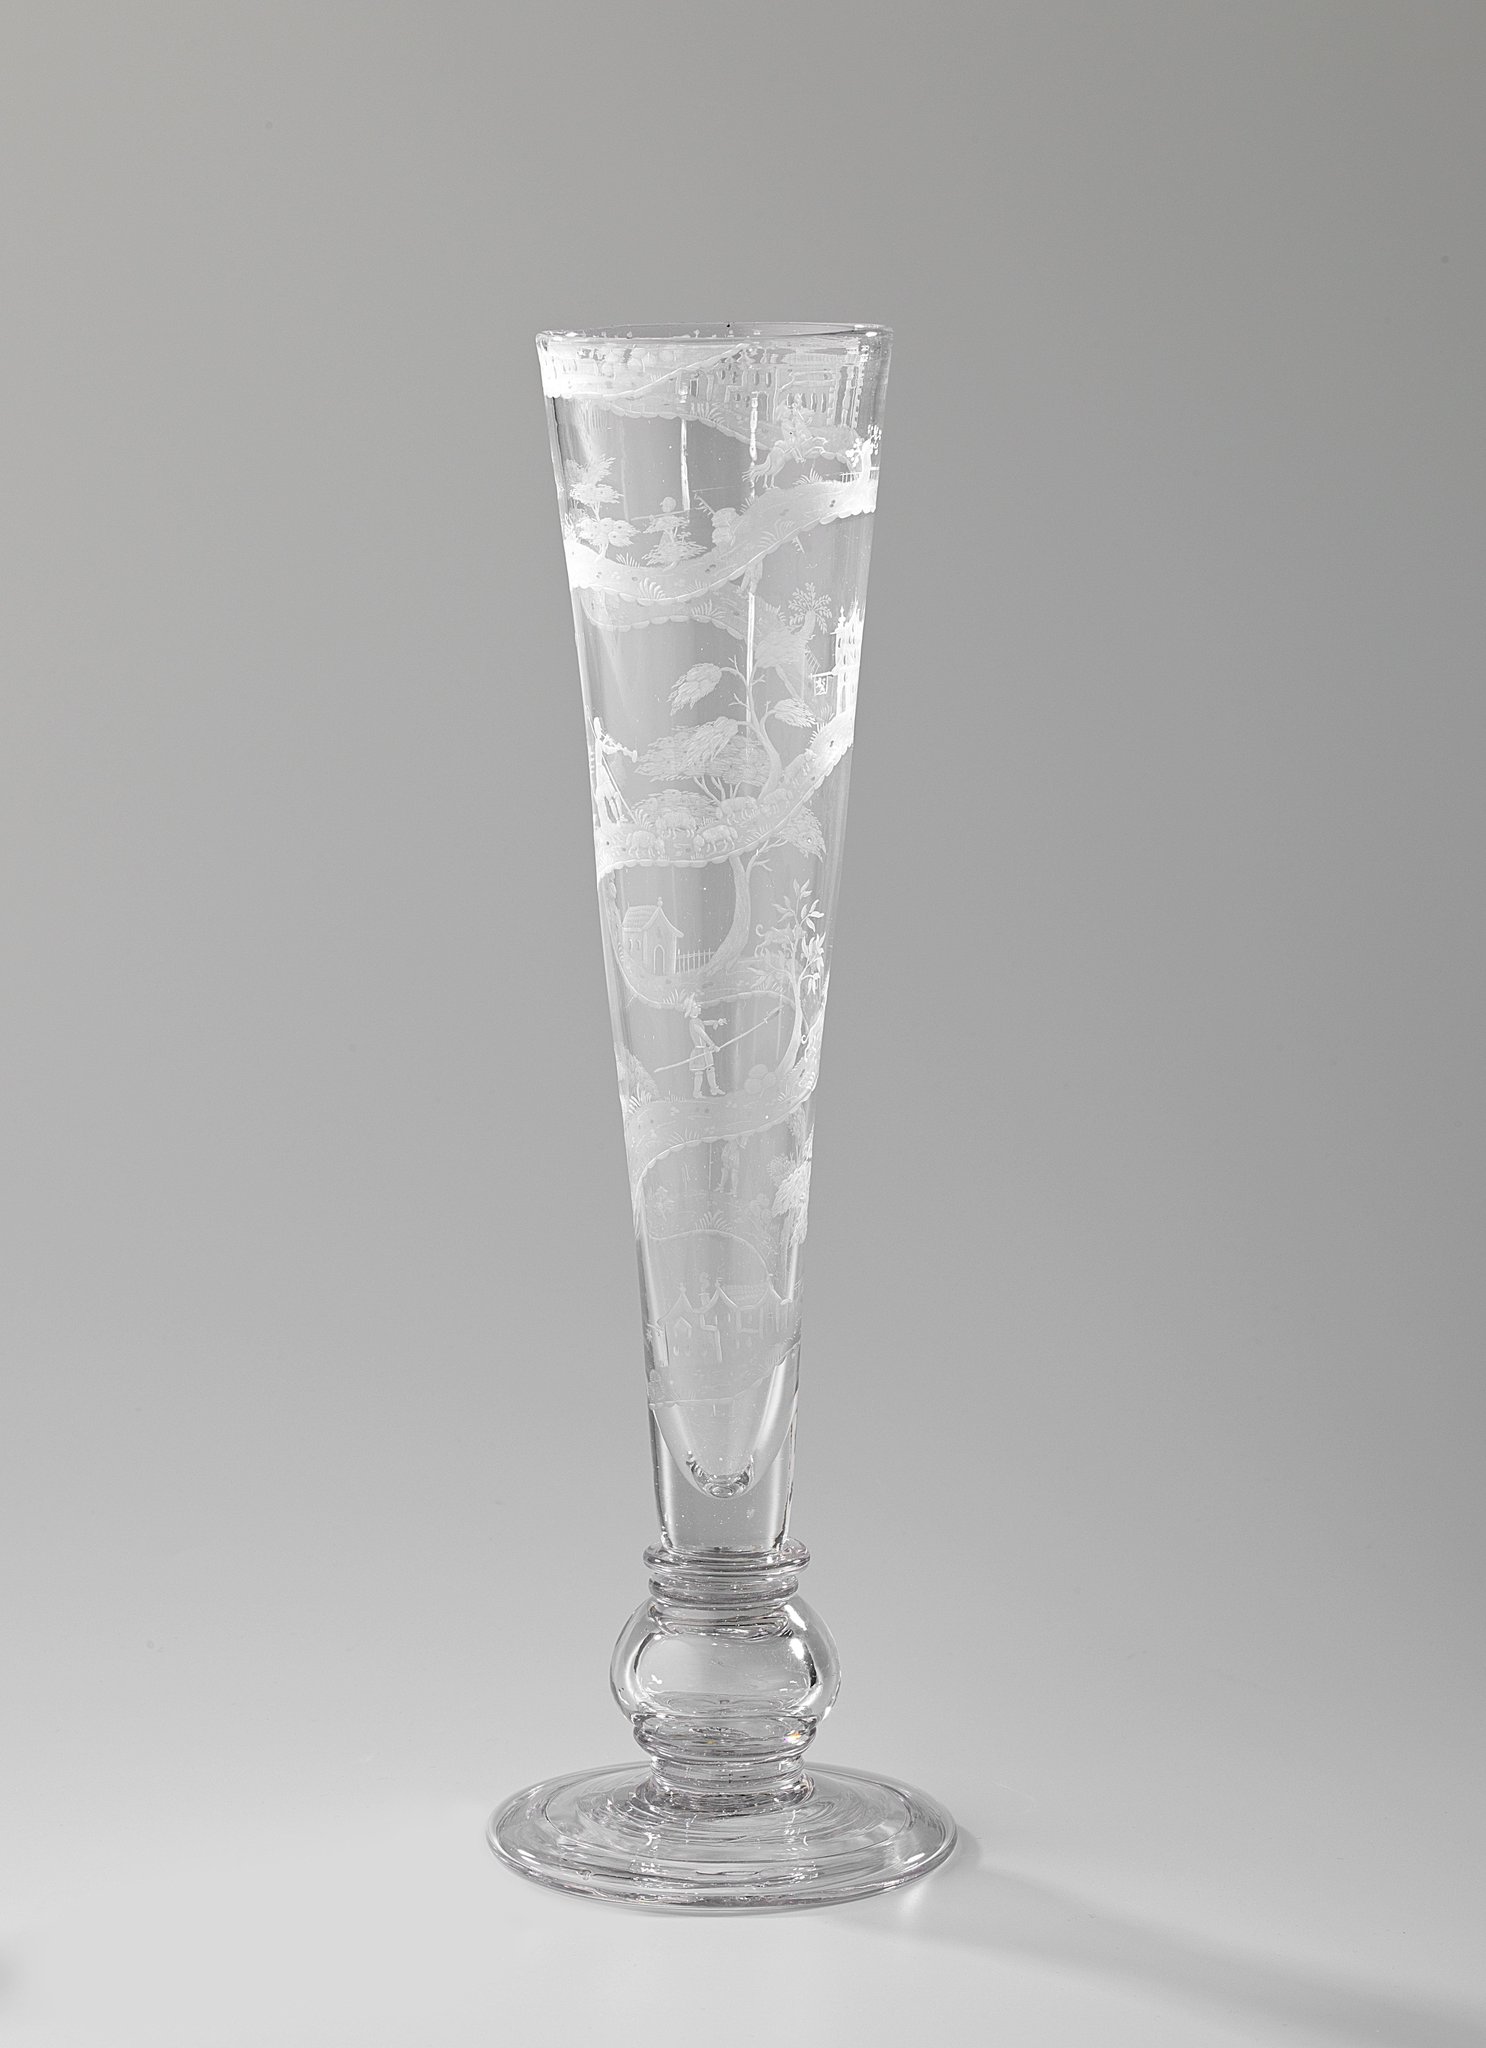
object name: flute glass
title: Flute glass with a landscape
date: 1700-1725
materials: glass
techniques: glassblowing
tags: landscapes in the temperate zone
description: The late 17th century was the highpoint for glass production in Bohemia. Bohemian glass was exported throughout Europe. It is extremely varied, ranging from simple, often coarsely engraved pieces to exceptionally original designs. This flute glass, decorated with a spiralling landscape, is a fine example of the latter category.